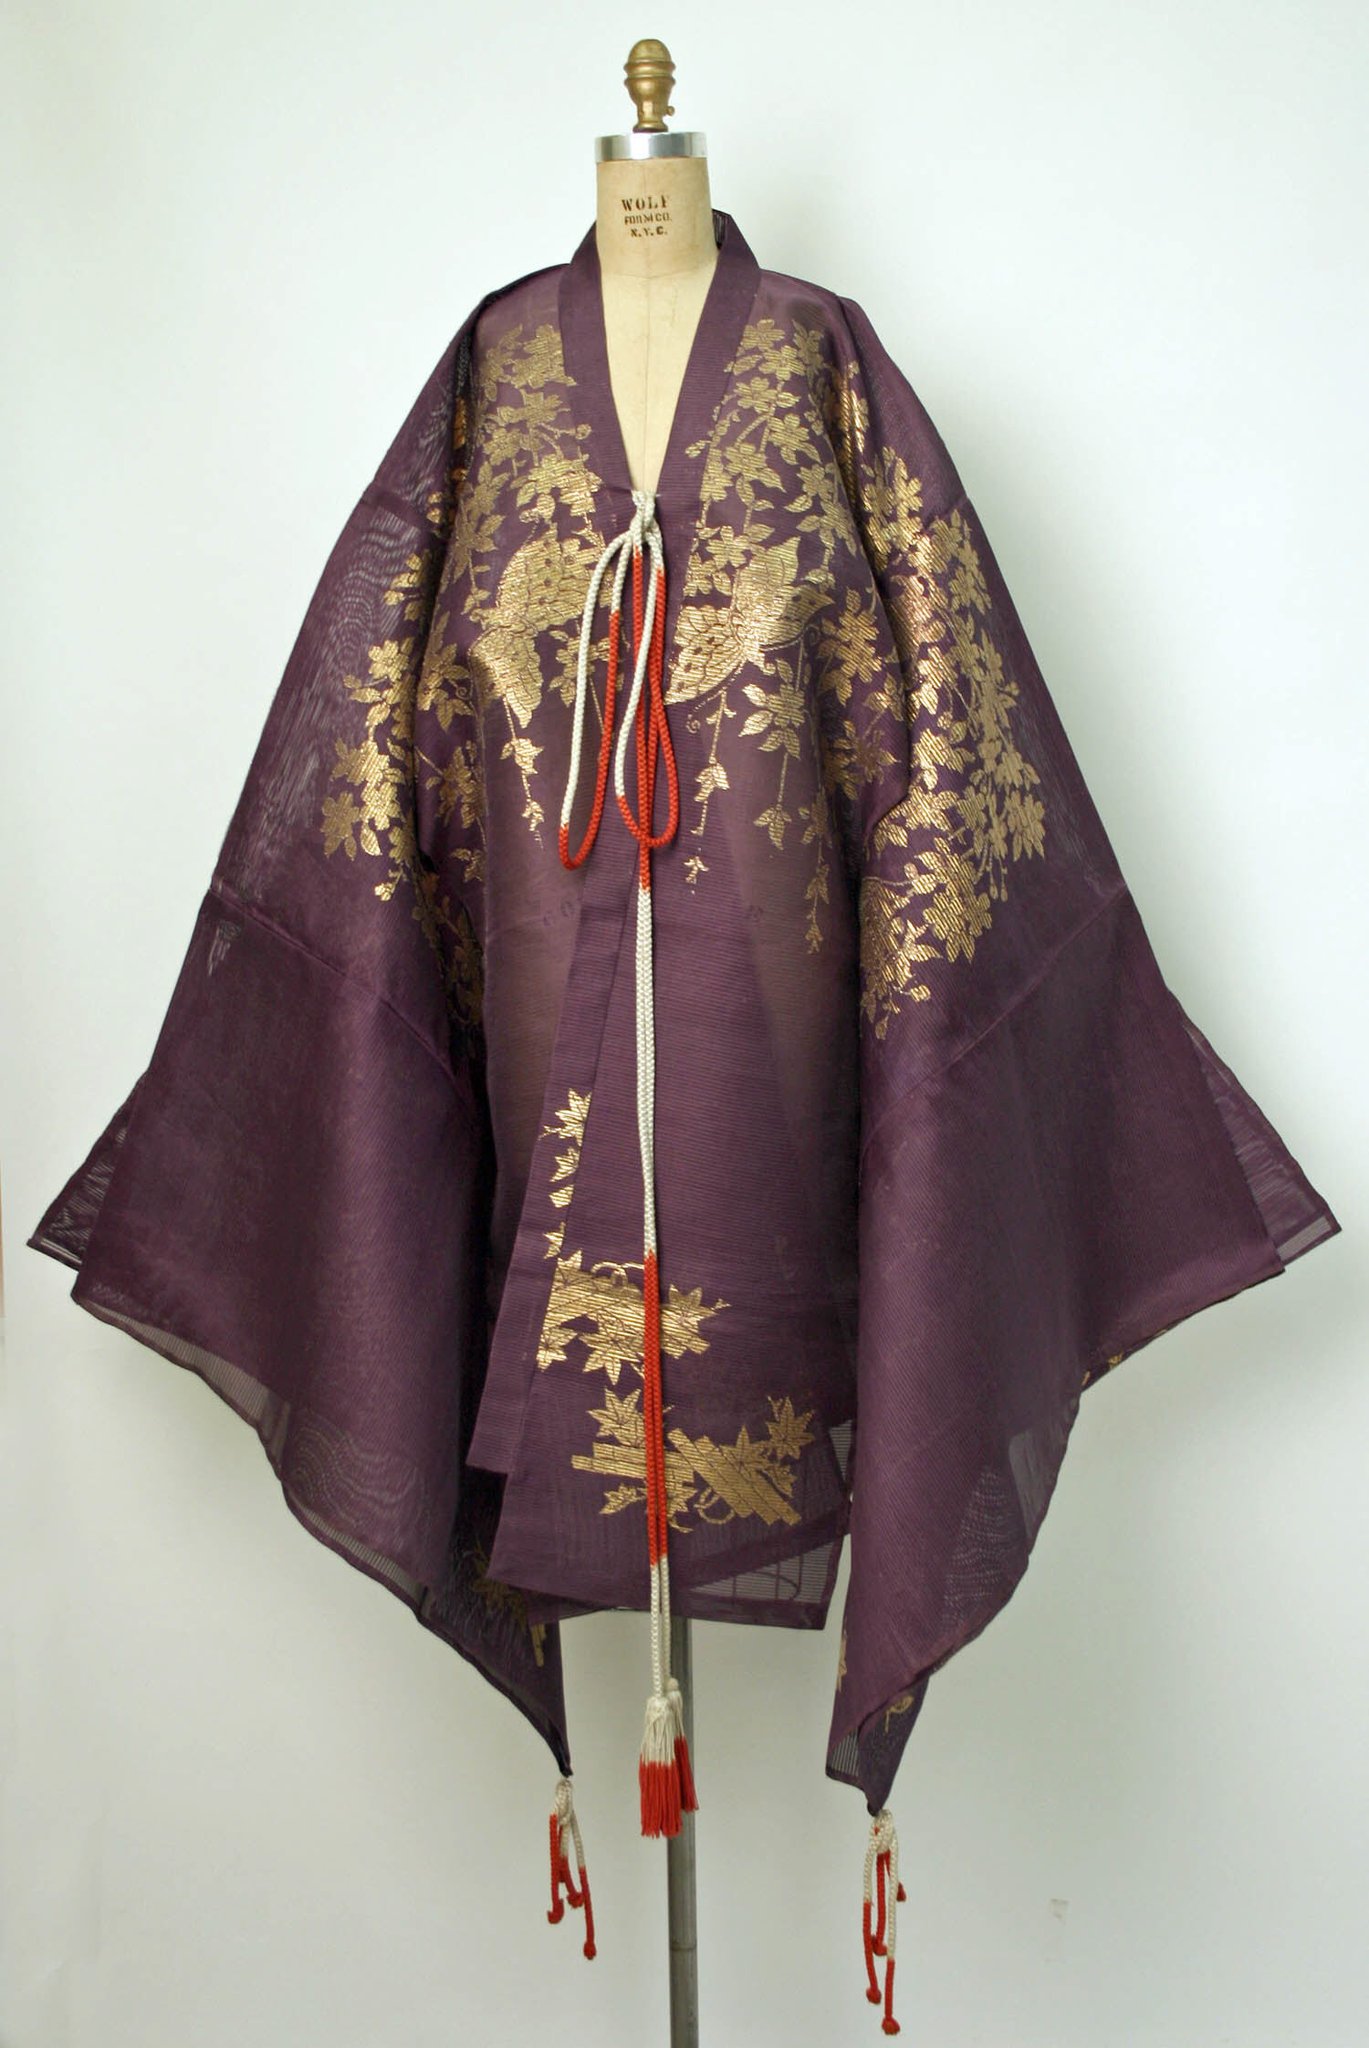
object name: theatrical costume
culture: japanese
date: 1701-1800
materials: cotton, paper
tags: birds